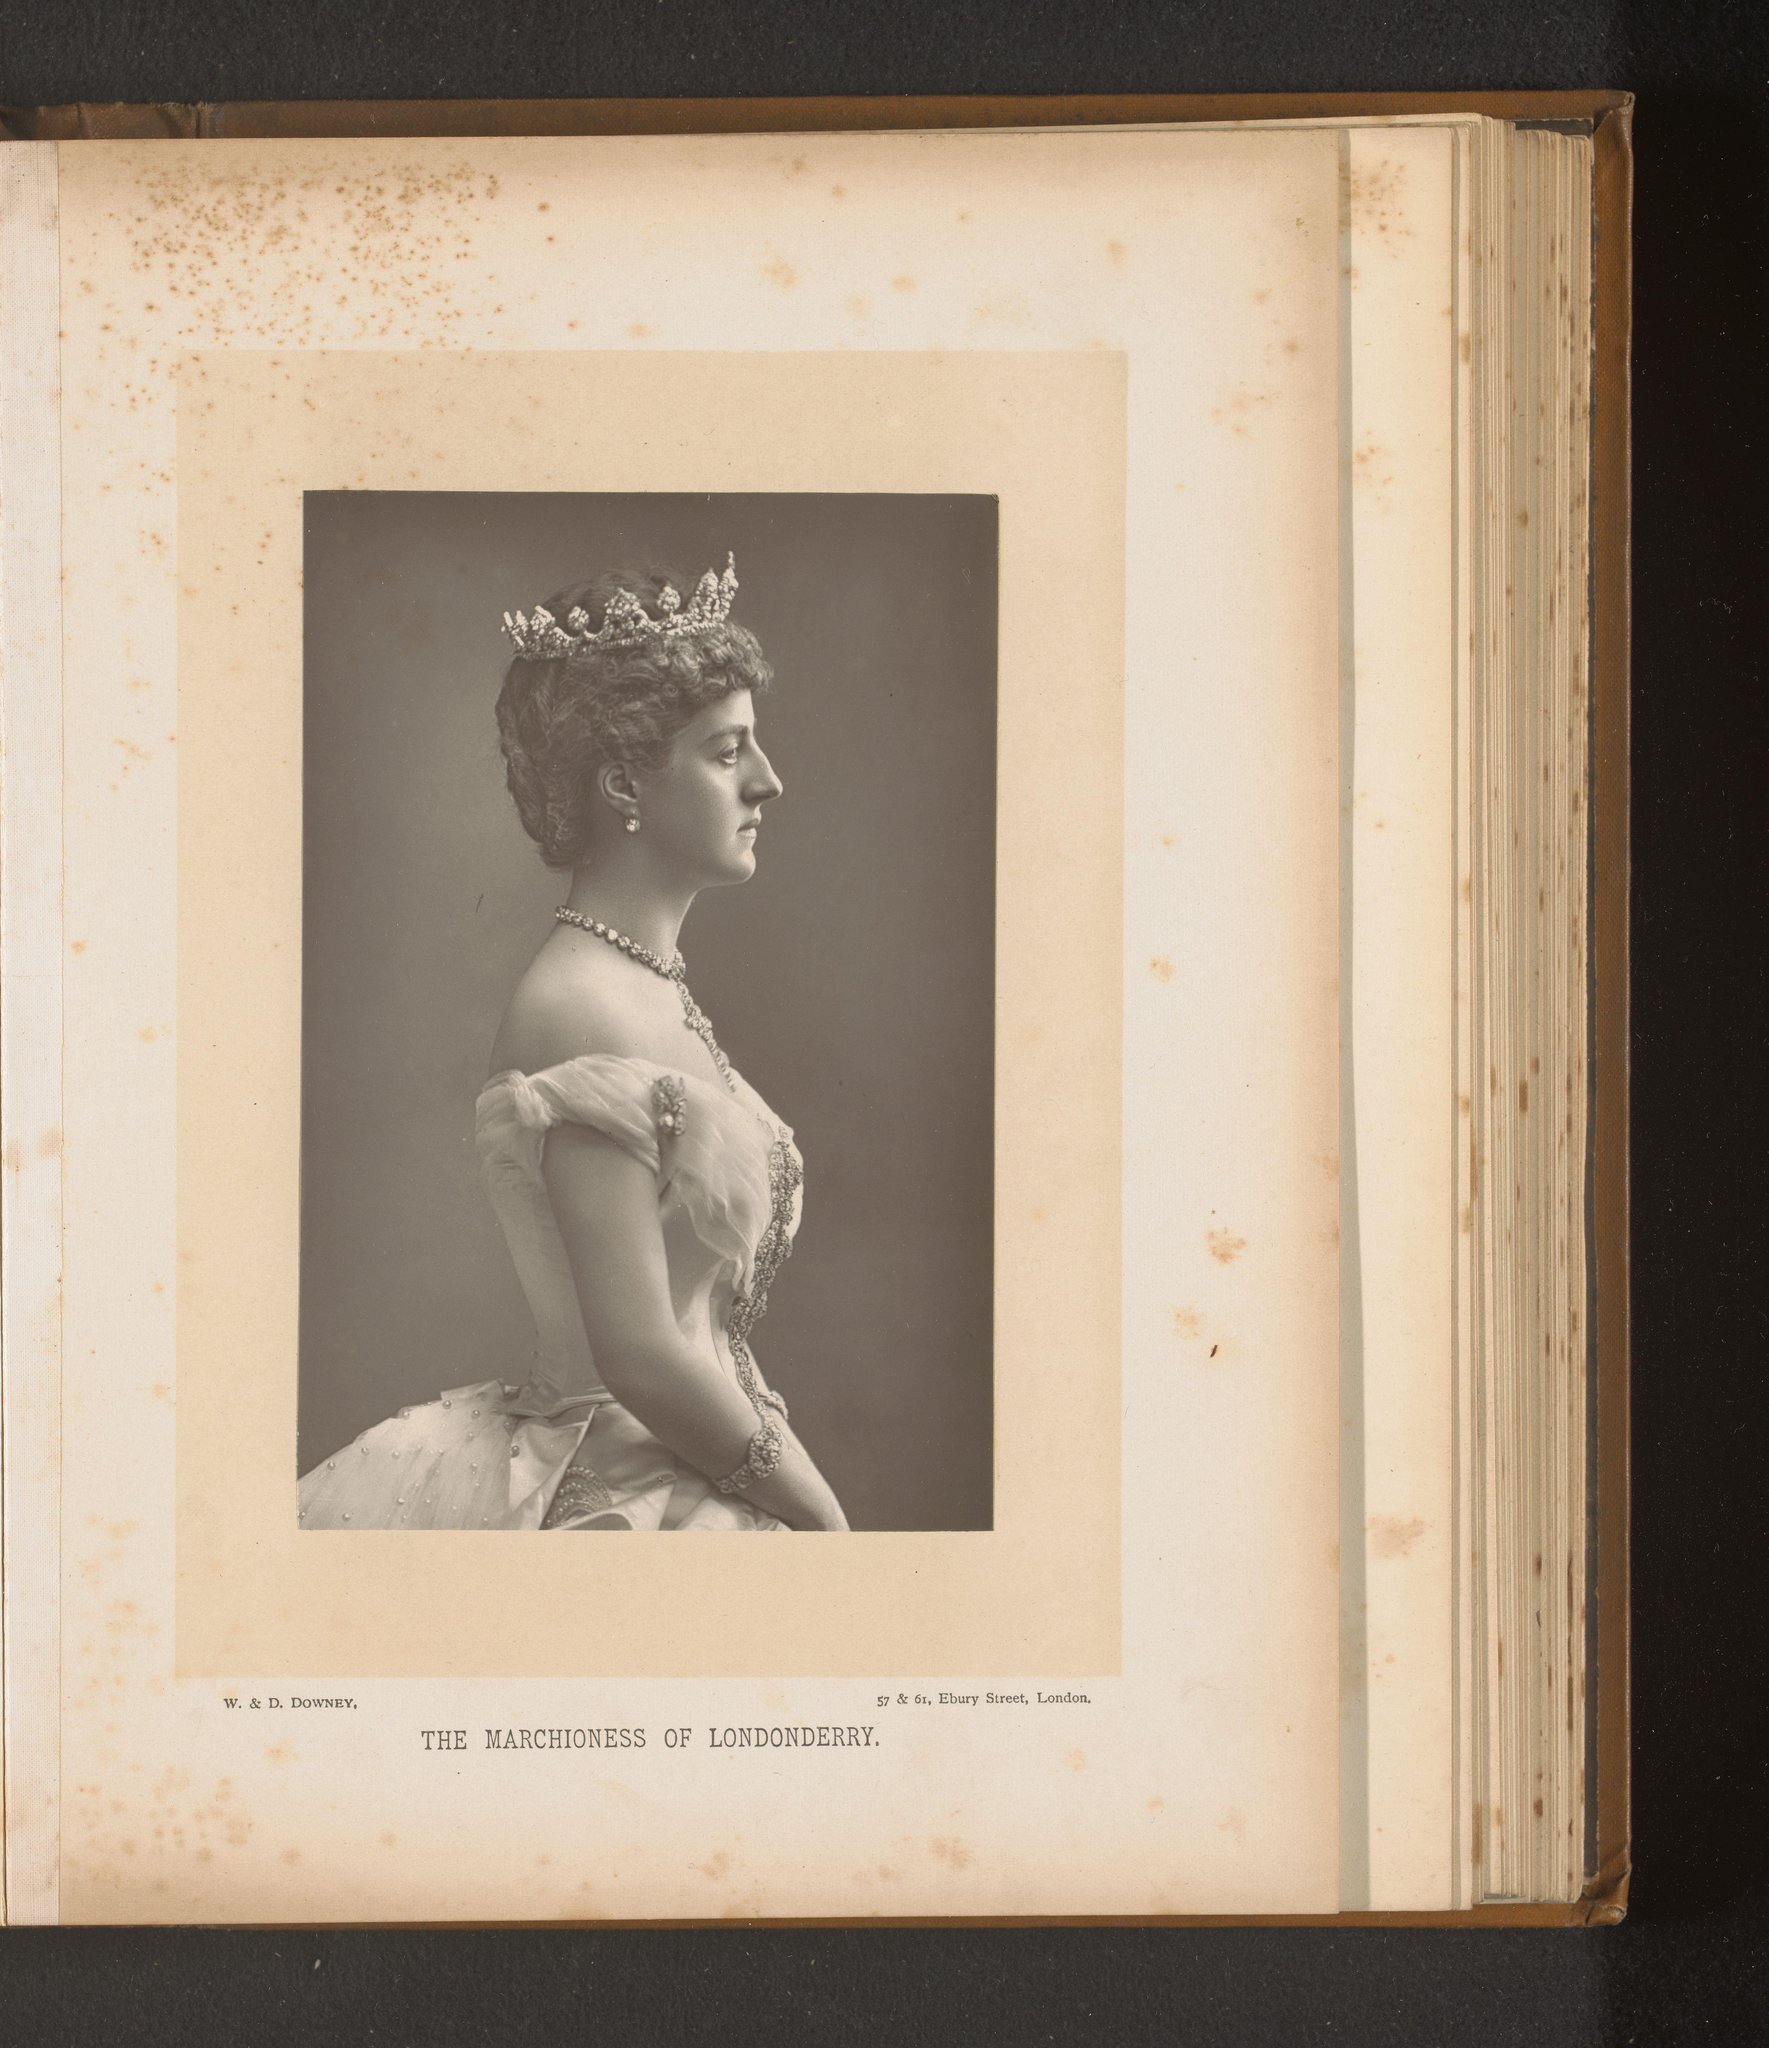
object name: page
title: Portret van Theresa Susey Helen Talbot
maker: Anonymous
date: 1881-1891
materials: paper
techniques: woodburytype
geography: london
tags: adult woman, historical persons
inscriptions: inscription: ‘57 & 61, Elbury Street, London.’